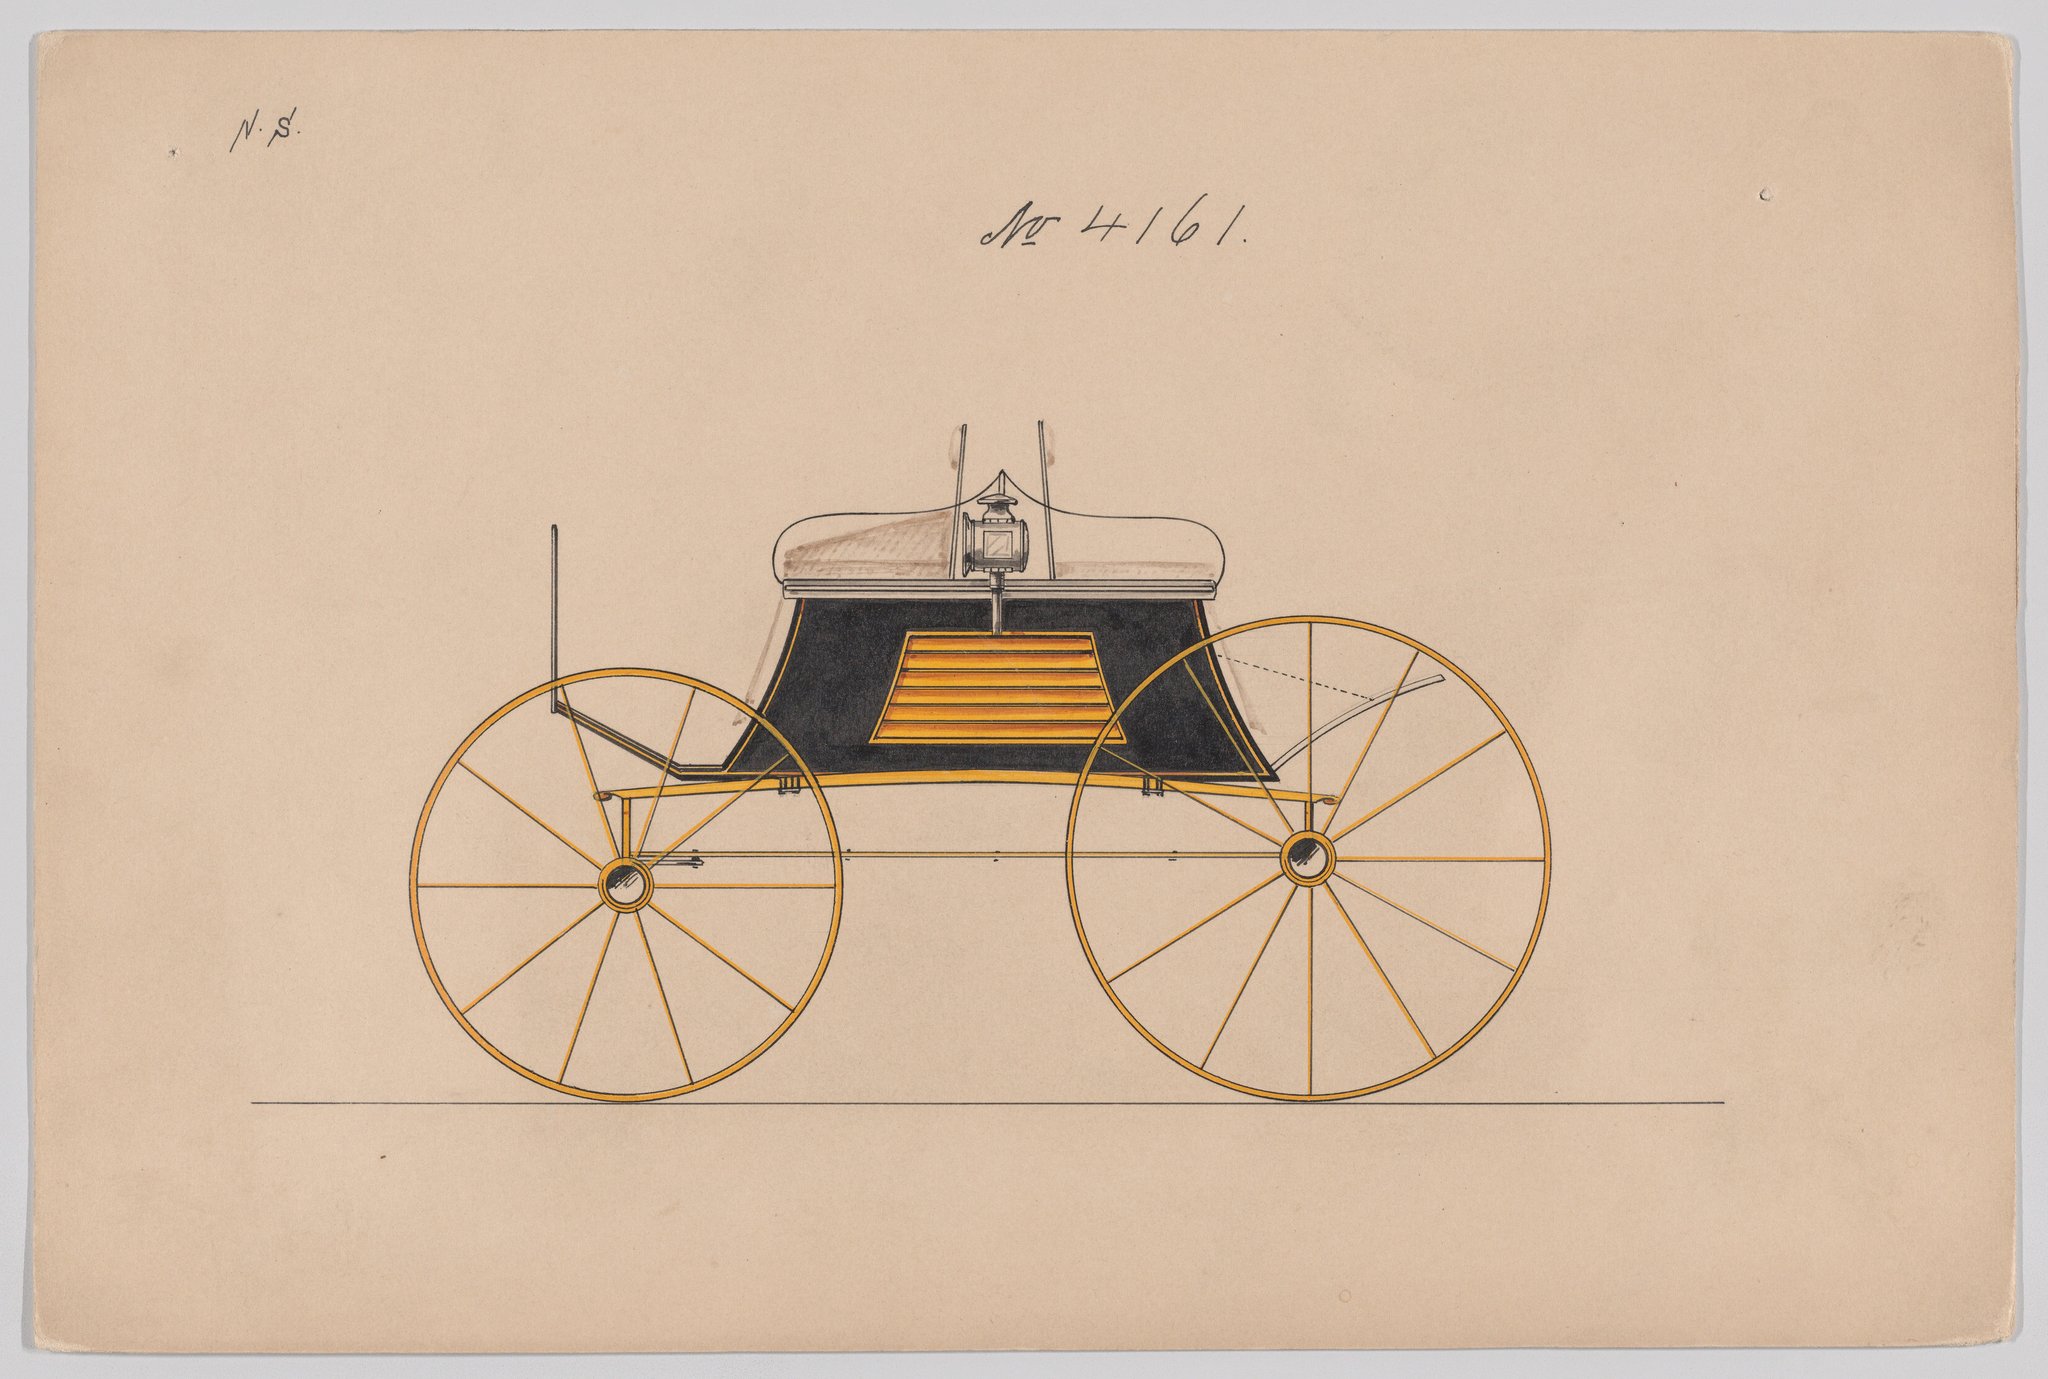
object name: drawing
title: Side Bar Game Cart, #4161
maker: brewster & co.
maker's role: manufacturer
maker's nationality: american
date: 1892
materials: gouache, gum arabic, ink, watercolor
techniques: pen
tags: carriages